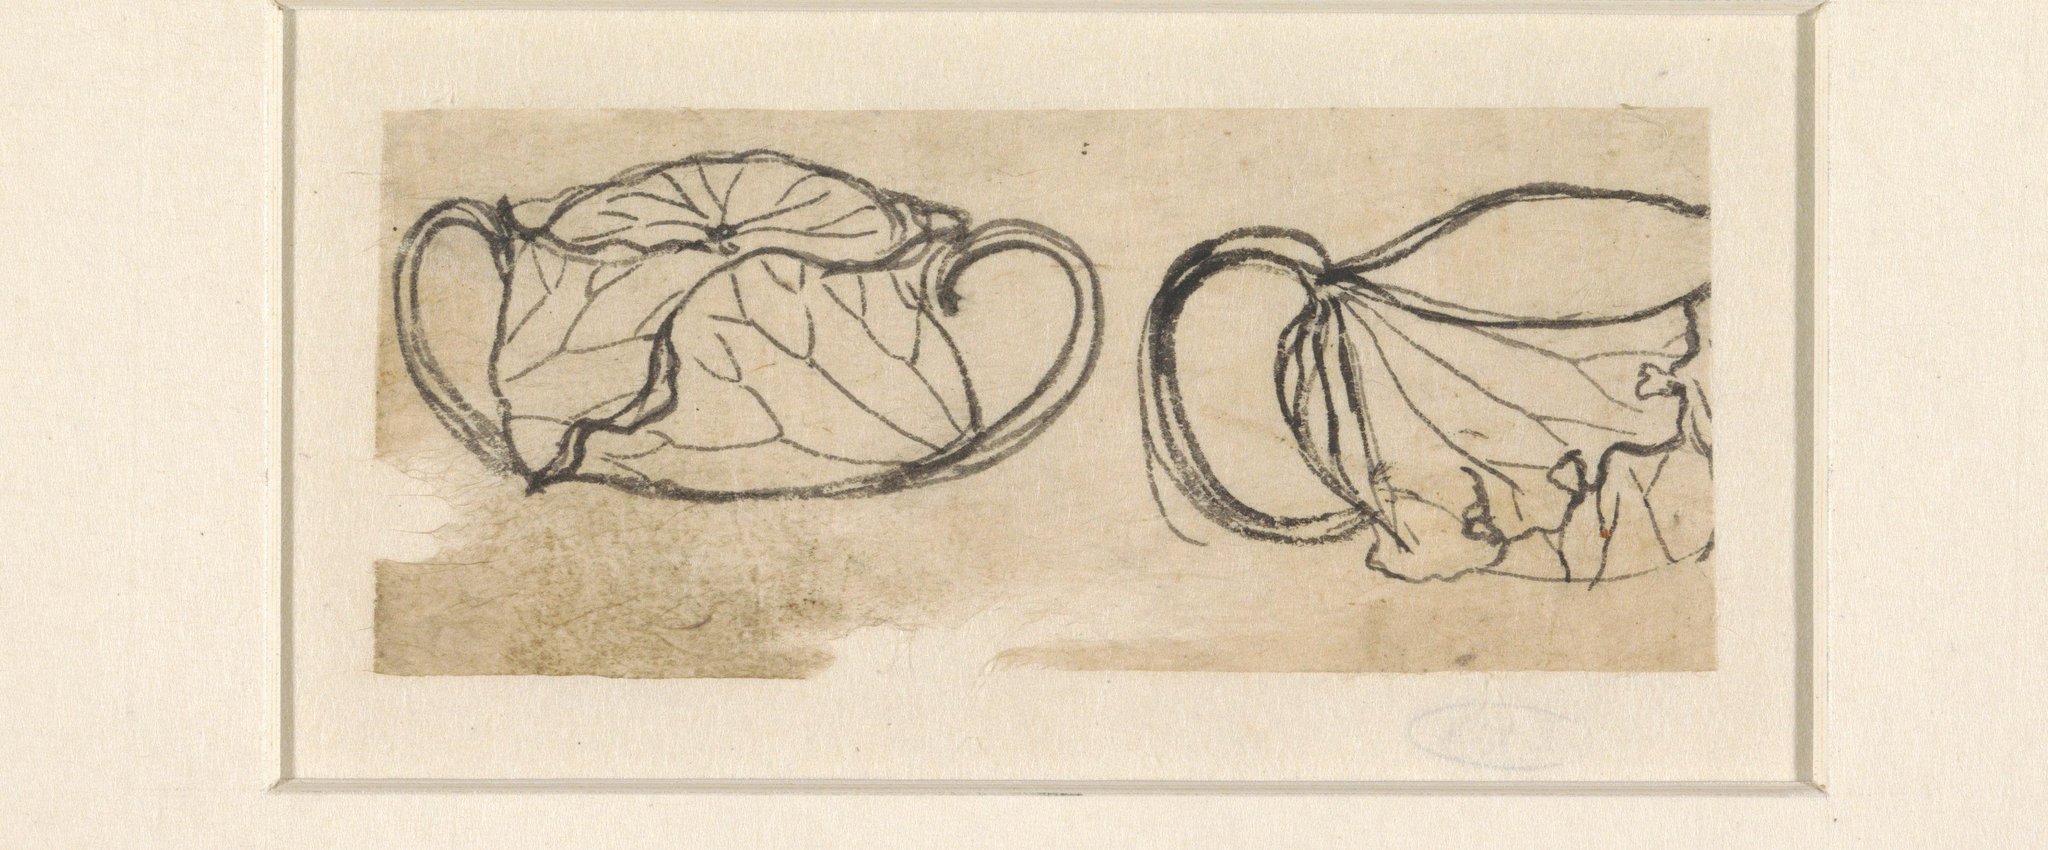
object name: drawing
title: Schetsblad met gevouwen lotusbladeren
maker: utagawa kuniyoshi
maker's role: draughtsman, print maker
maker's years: 1798-1861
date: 1808-1861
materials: paper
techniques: brush